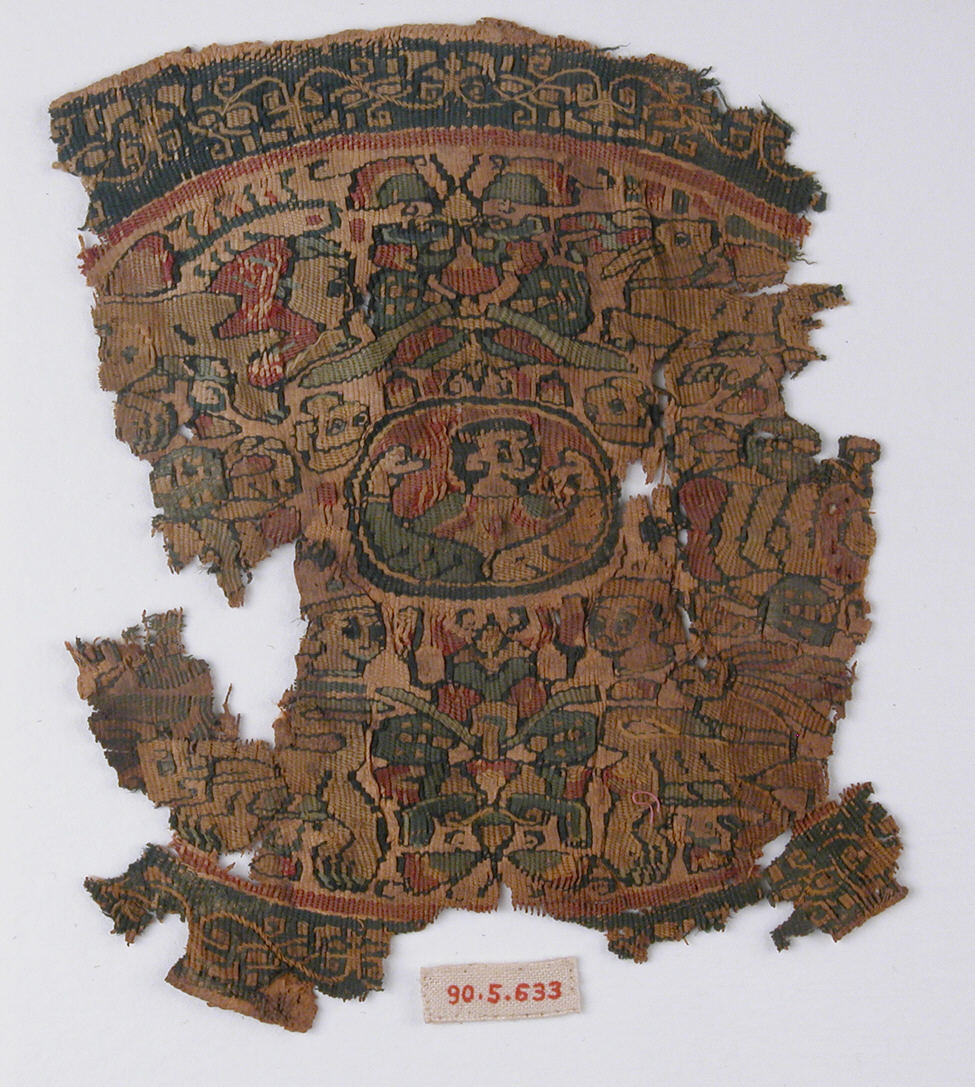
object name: textile fragment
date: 601-800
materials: linen, wool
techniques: weave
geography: egypt